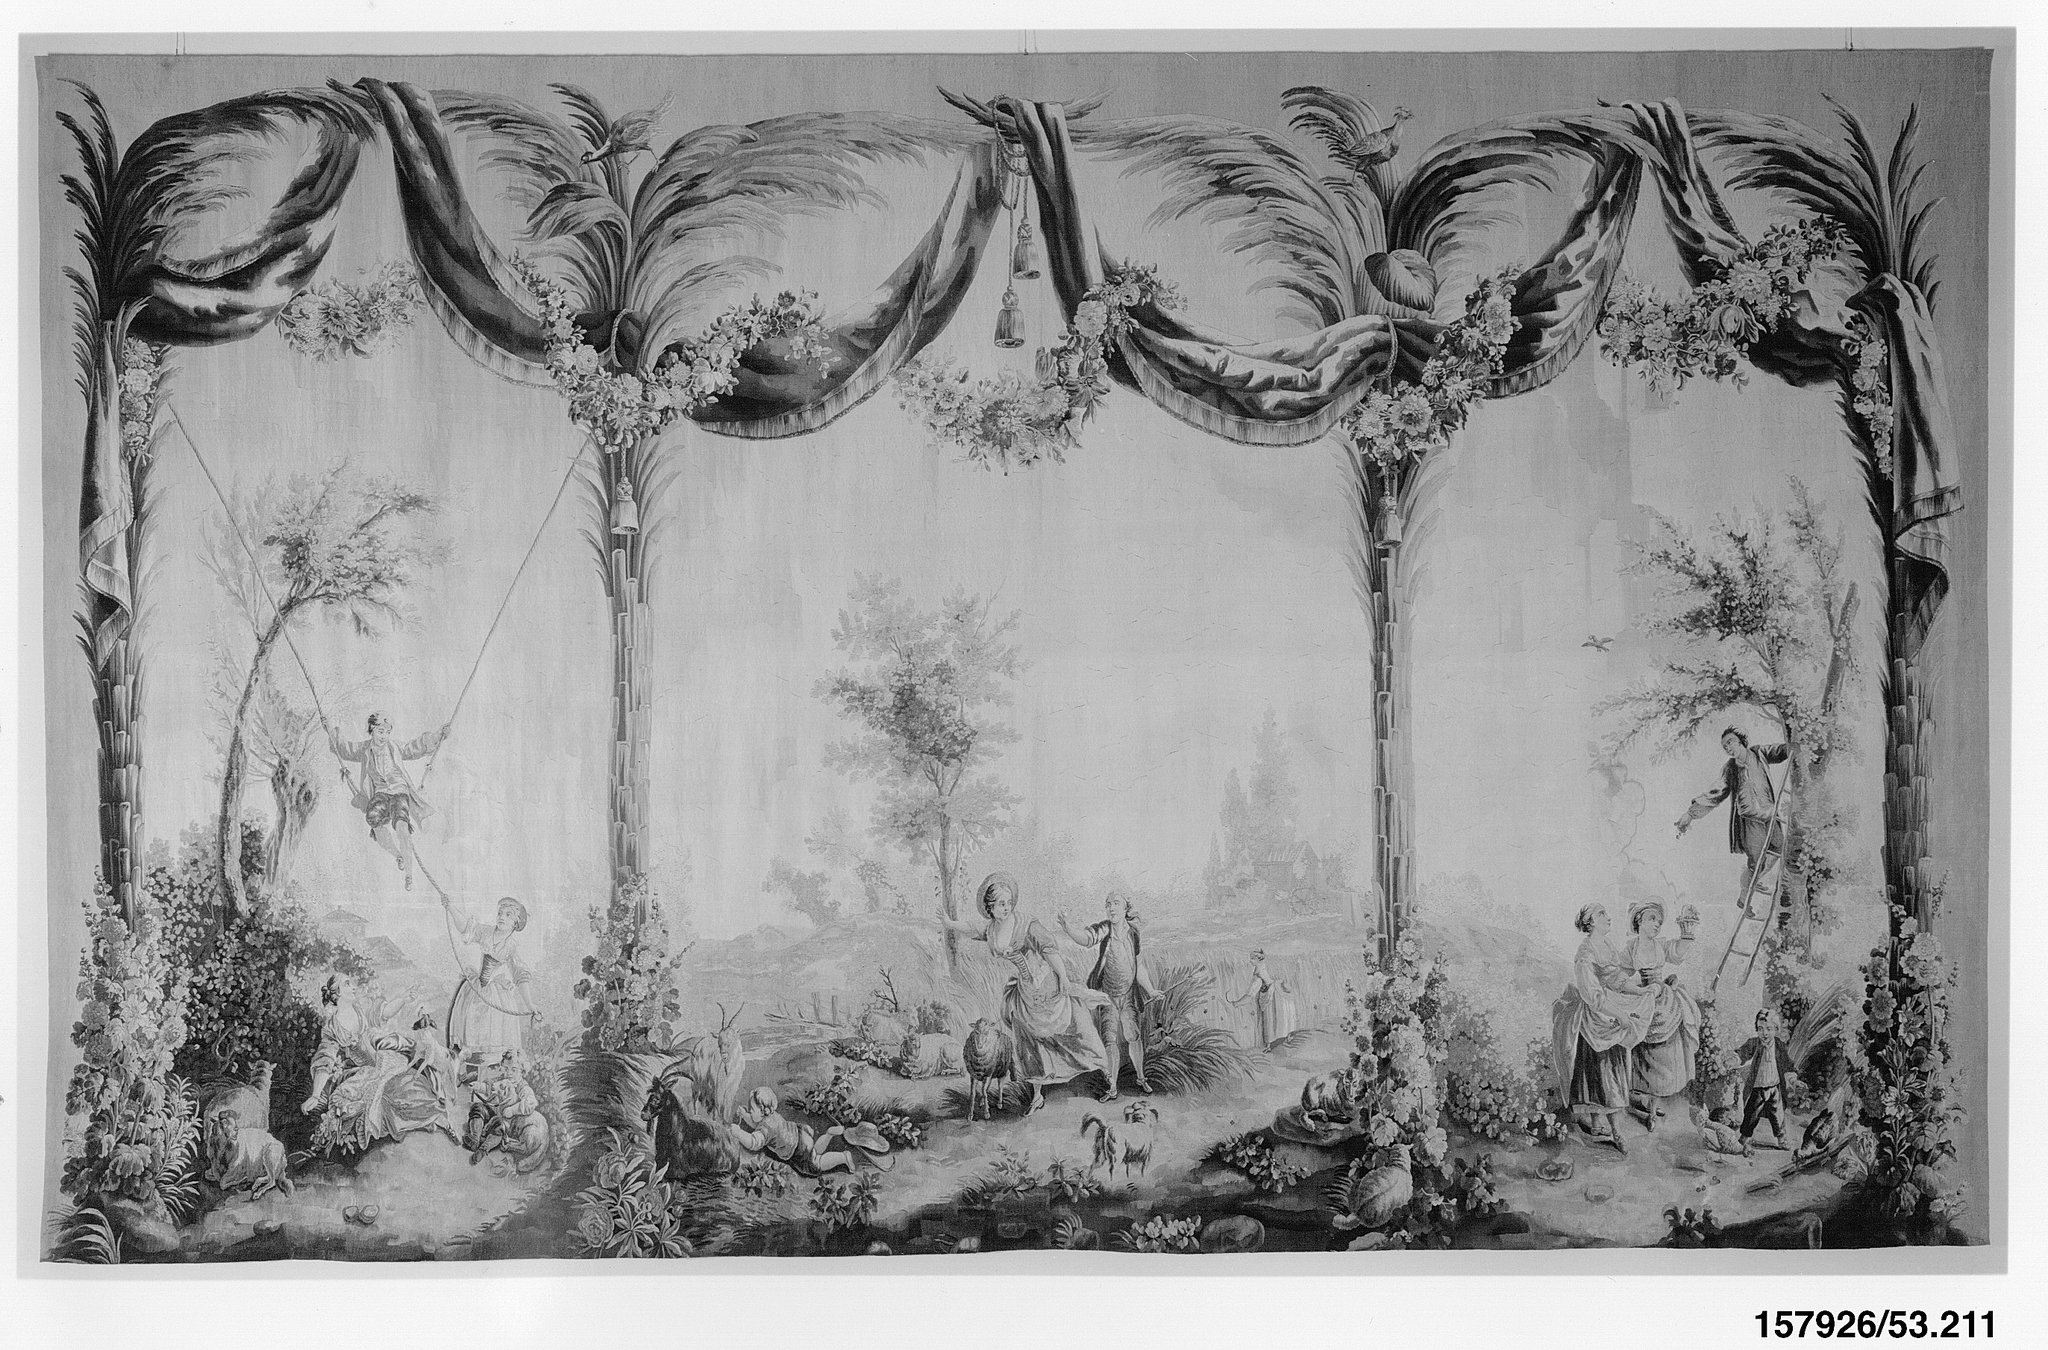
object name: tapestry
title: The Swing, The Harvest, and Cherry Picking from a set of the Pastorals with Blue Draperies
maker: jean-baptiste huet i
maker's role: designer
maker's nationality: french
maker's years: 1745-1811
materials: silk, wool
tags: children,men,women,landscapes